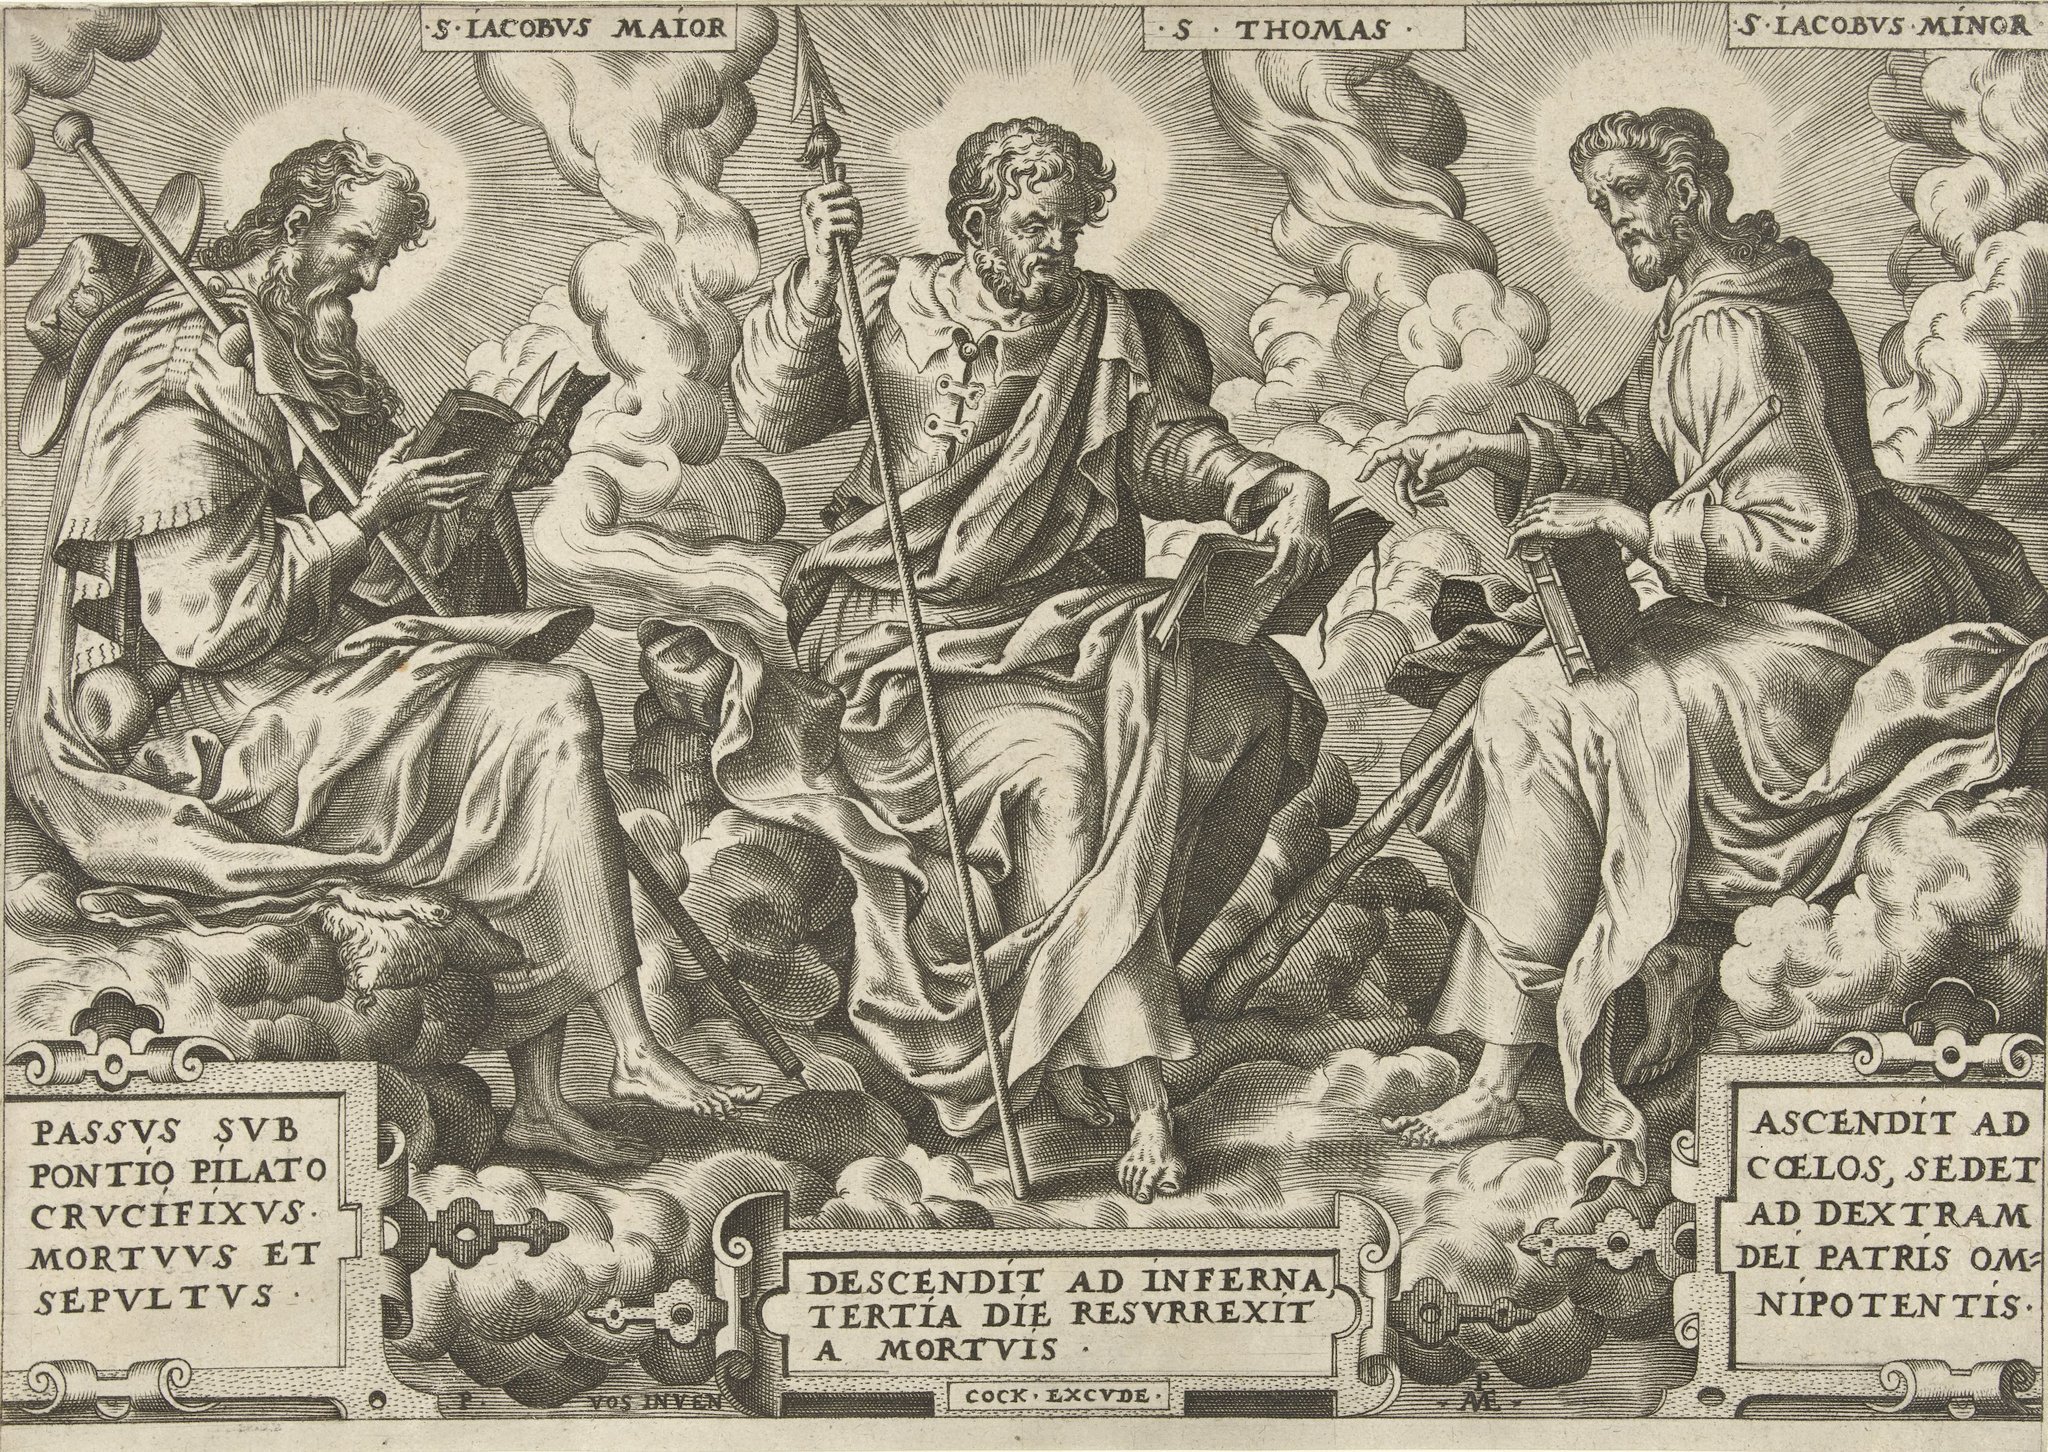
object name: print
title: Drie apostelen Jakobus de Meerdere, Tomas en Jakobus de Mindere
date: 1568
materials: paper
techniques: engraving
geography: antwerp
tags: the apostle thomas; possible attributes: book, chalice, girdle, heart, lance or spear, scroll, square, stones, the apostle james the less, first bishop of jerusalem; possible attributes: book, fuller's club, scroll, the apostle james the great; possible attributes: book, pilgrim's cloak, hat, shell, staff, and wallet, scroll, sword, the twelve apostles (as a group), usually with books or scrolls (not in biblical context) - ii - the apostles with matthias instead of judas iscariot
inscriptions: collector's mark: Lugt 2228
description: De apostelen Jakobus de Meerdere, Tomas en Jakobus de Mindere met om hun hoofd een stralenkrans, gezeten tussen de wolken met hun attributen, respectievelijk staf, speer en knuppel. Onder elke apostel een deel van de Symbolum Apostolicum, de apostolische geloofsbelijdenis in het Latijn.